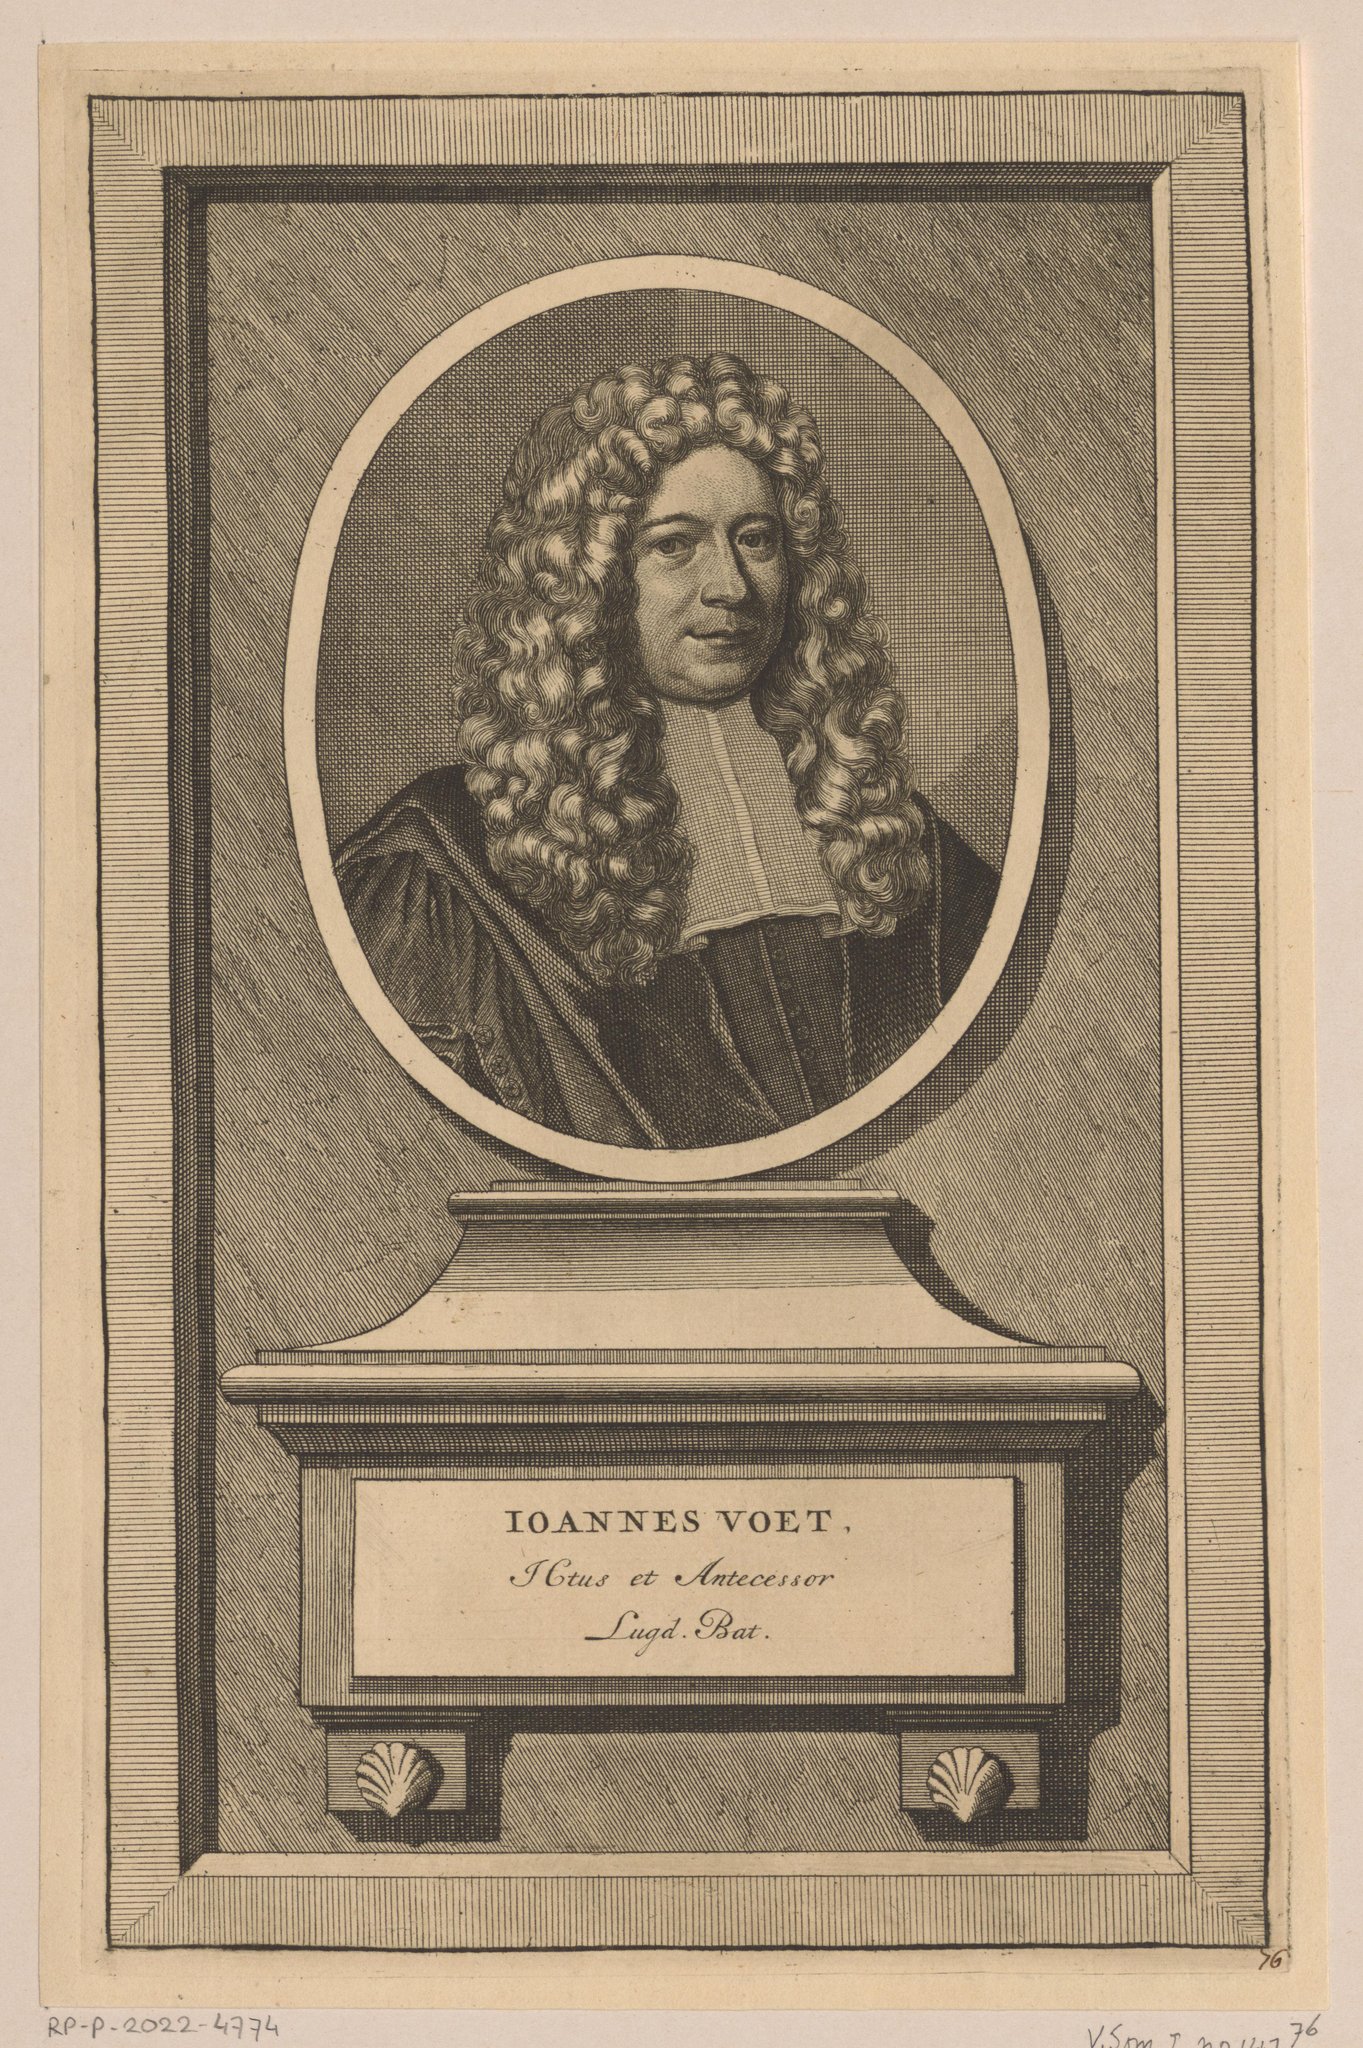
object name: print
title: Beroemde mannen aan de universiteit van Leiden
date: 1716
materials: paper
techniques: engraving, etching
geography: leiden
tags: utrecht, scholar, philosopher, historical persons, lawyer, attorney at law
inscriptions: number: ‘76’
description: Rechtsonder handgeschreven genummerd: 76.